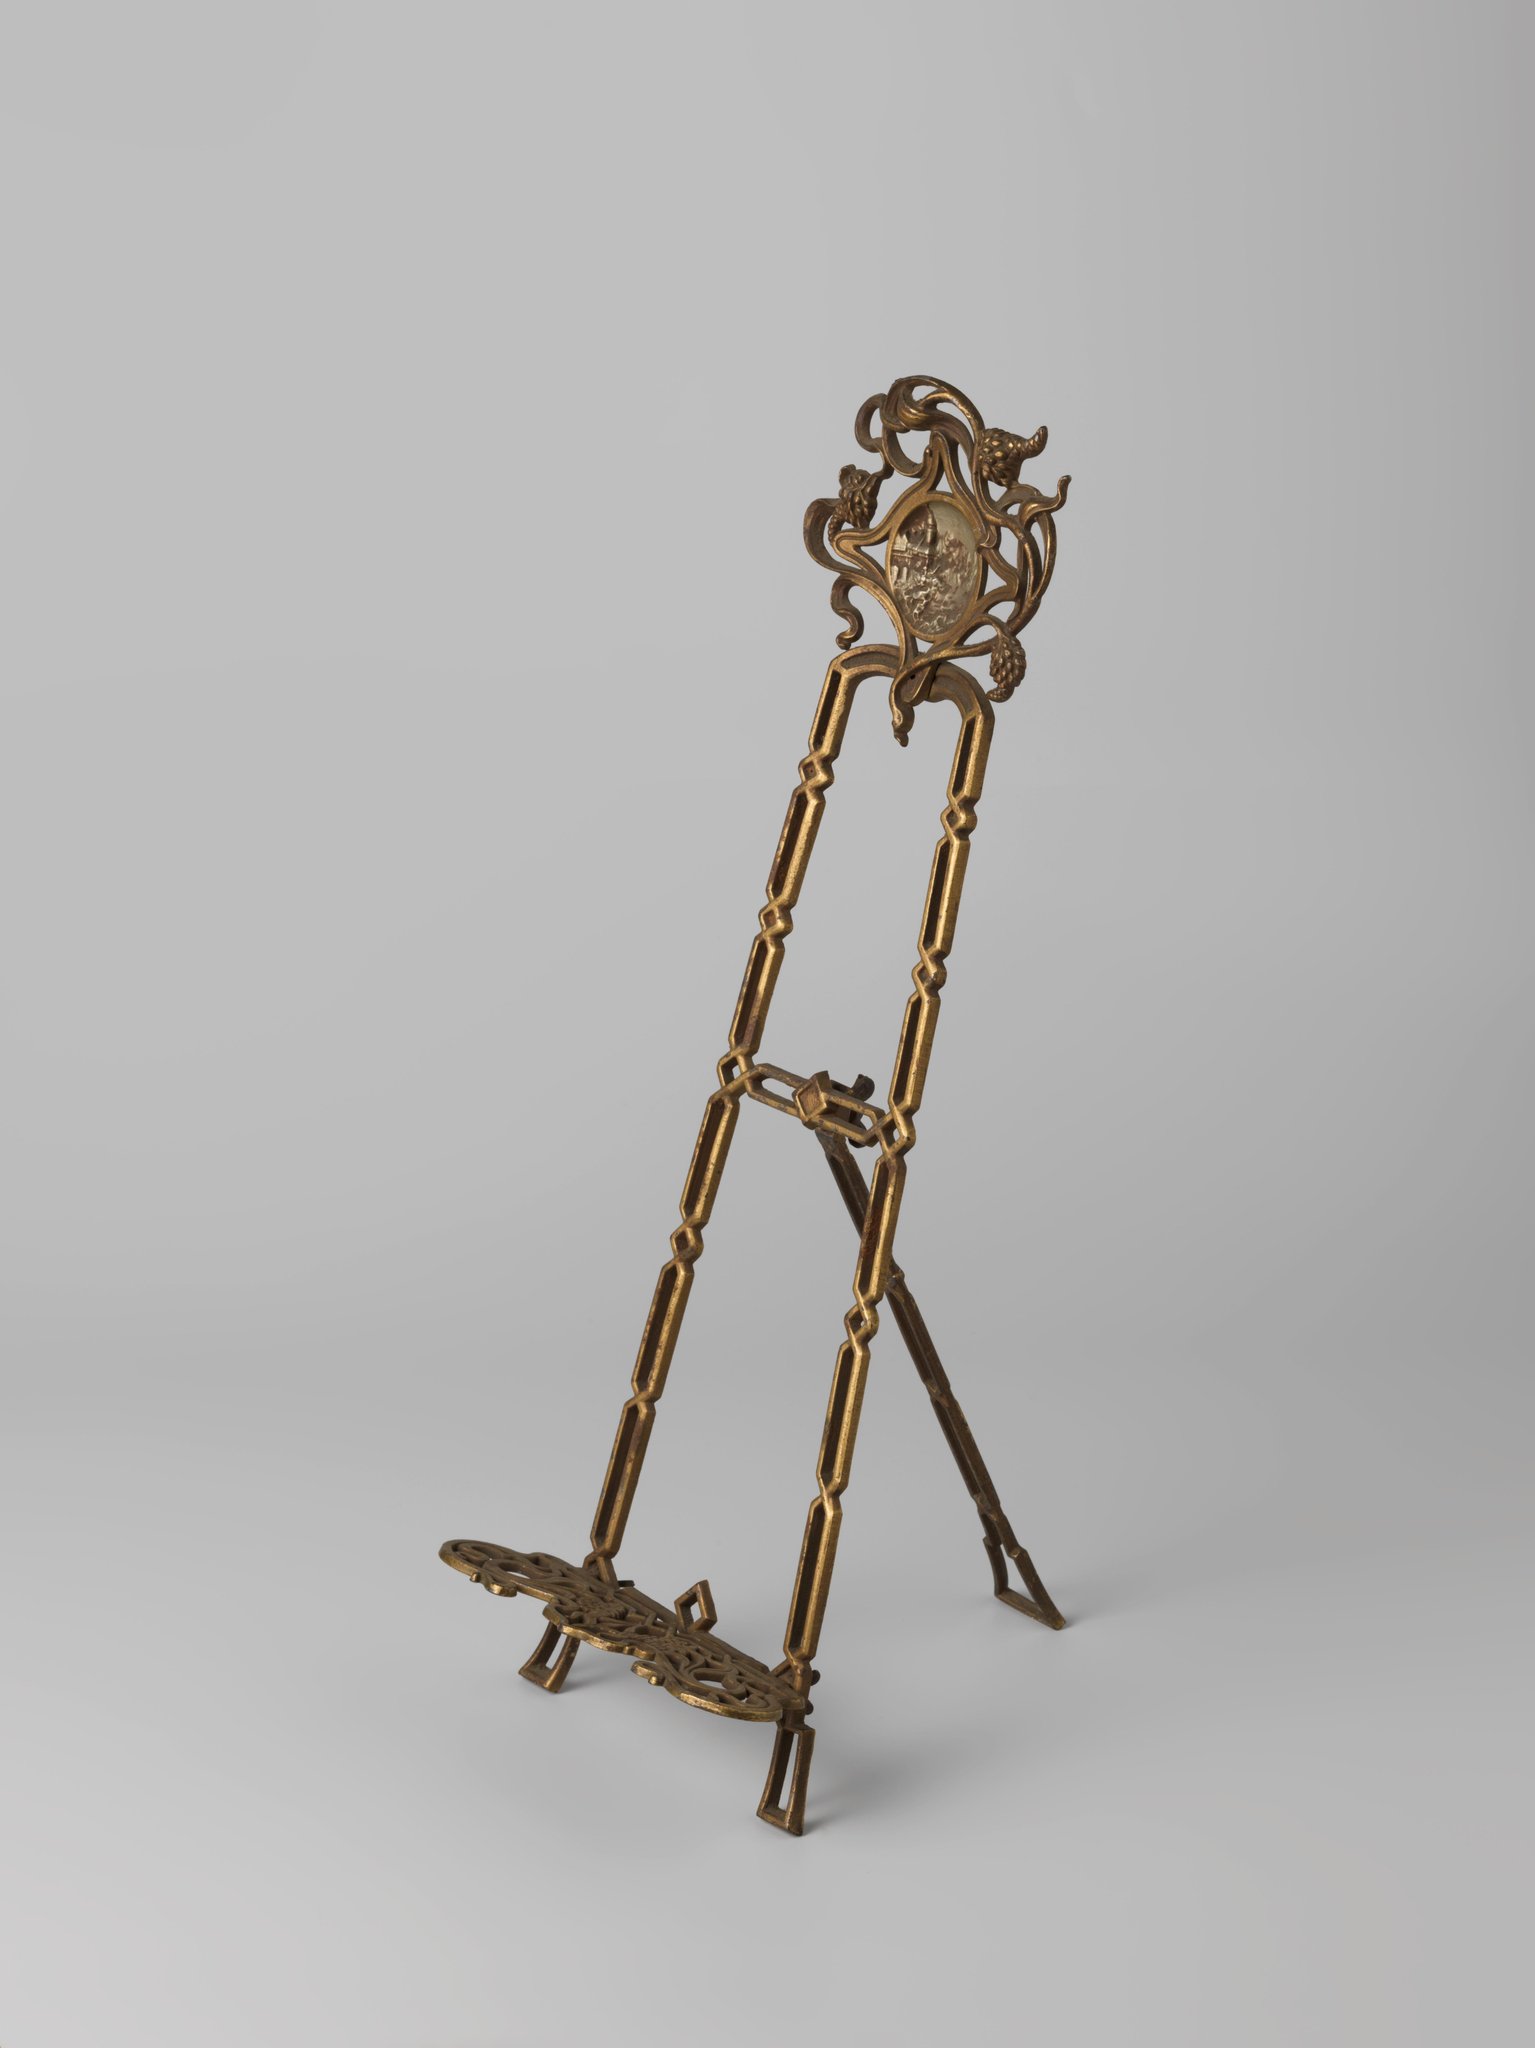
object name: stand support object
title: Fotoalbumstandaard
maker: Anonymous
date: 1880-1920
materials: iron